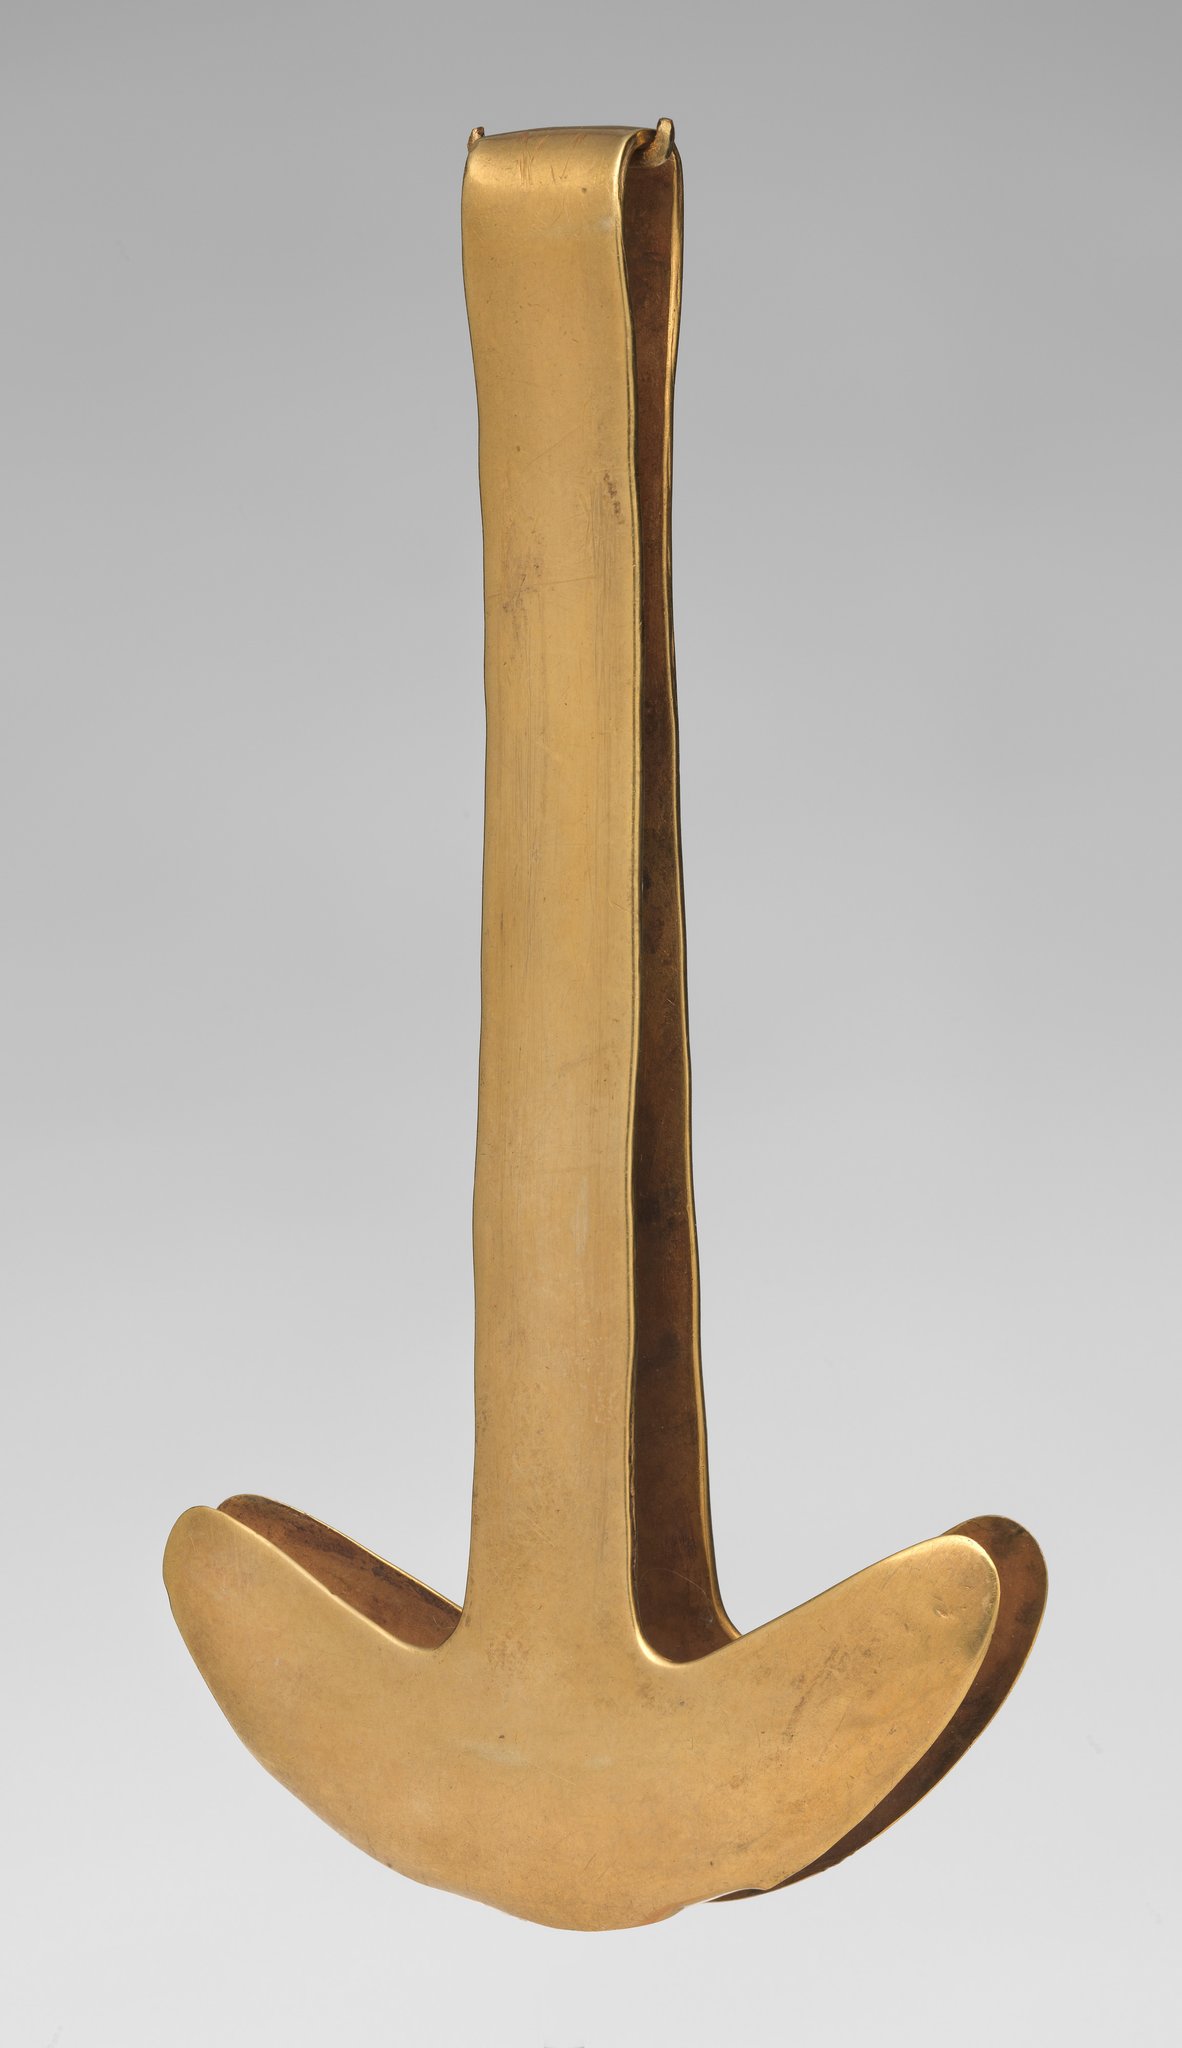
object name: tweezer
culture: calima or yotoco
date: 1-700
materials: gold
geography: colombia